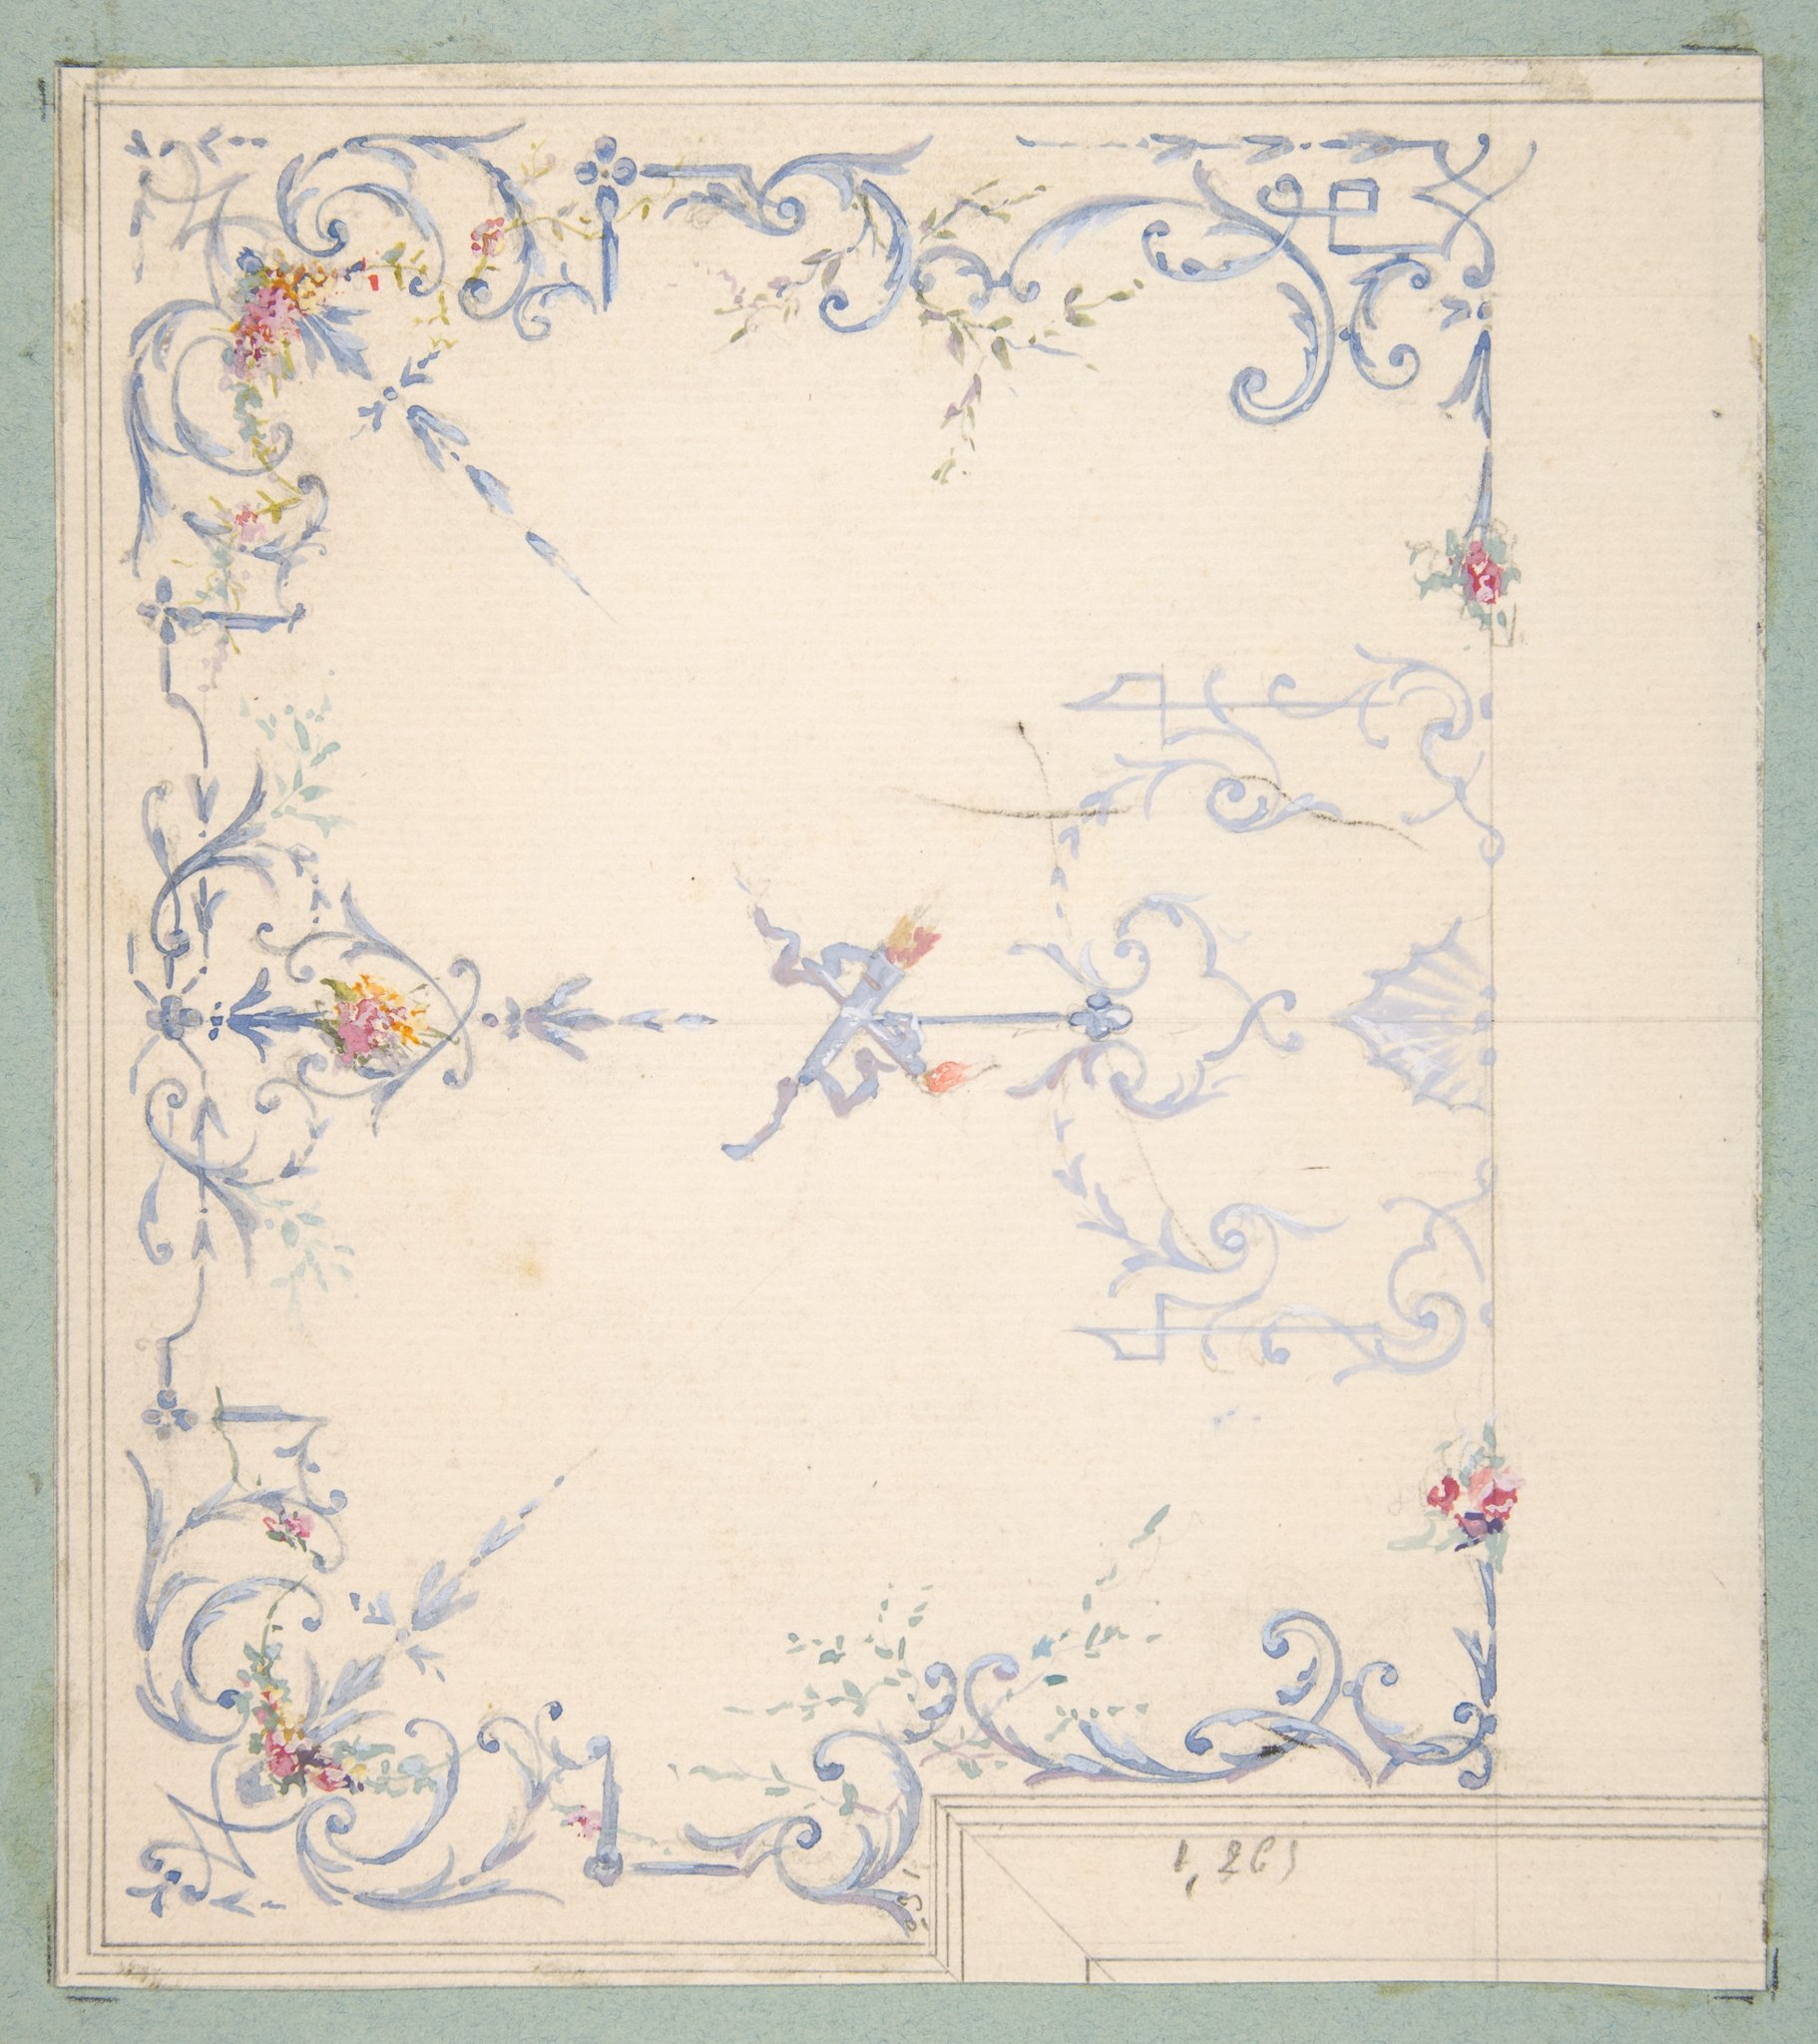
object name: drawing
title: Design for a ceiling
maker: jules-edmond-charles lachaise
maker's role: artist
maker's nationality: french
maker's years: 1897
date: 1851-1900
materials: gouache, graphite, watercolor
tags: ceilings